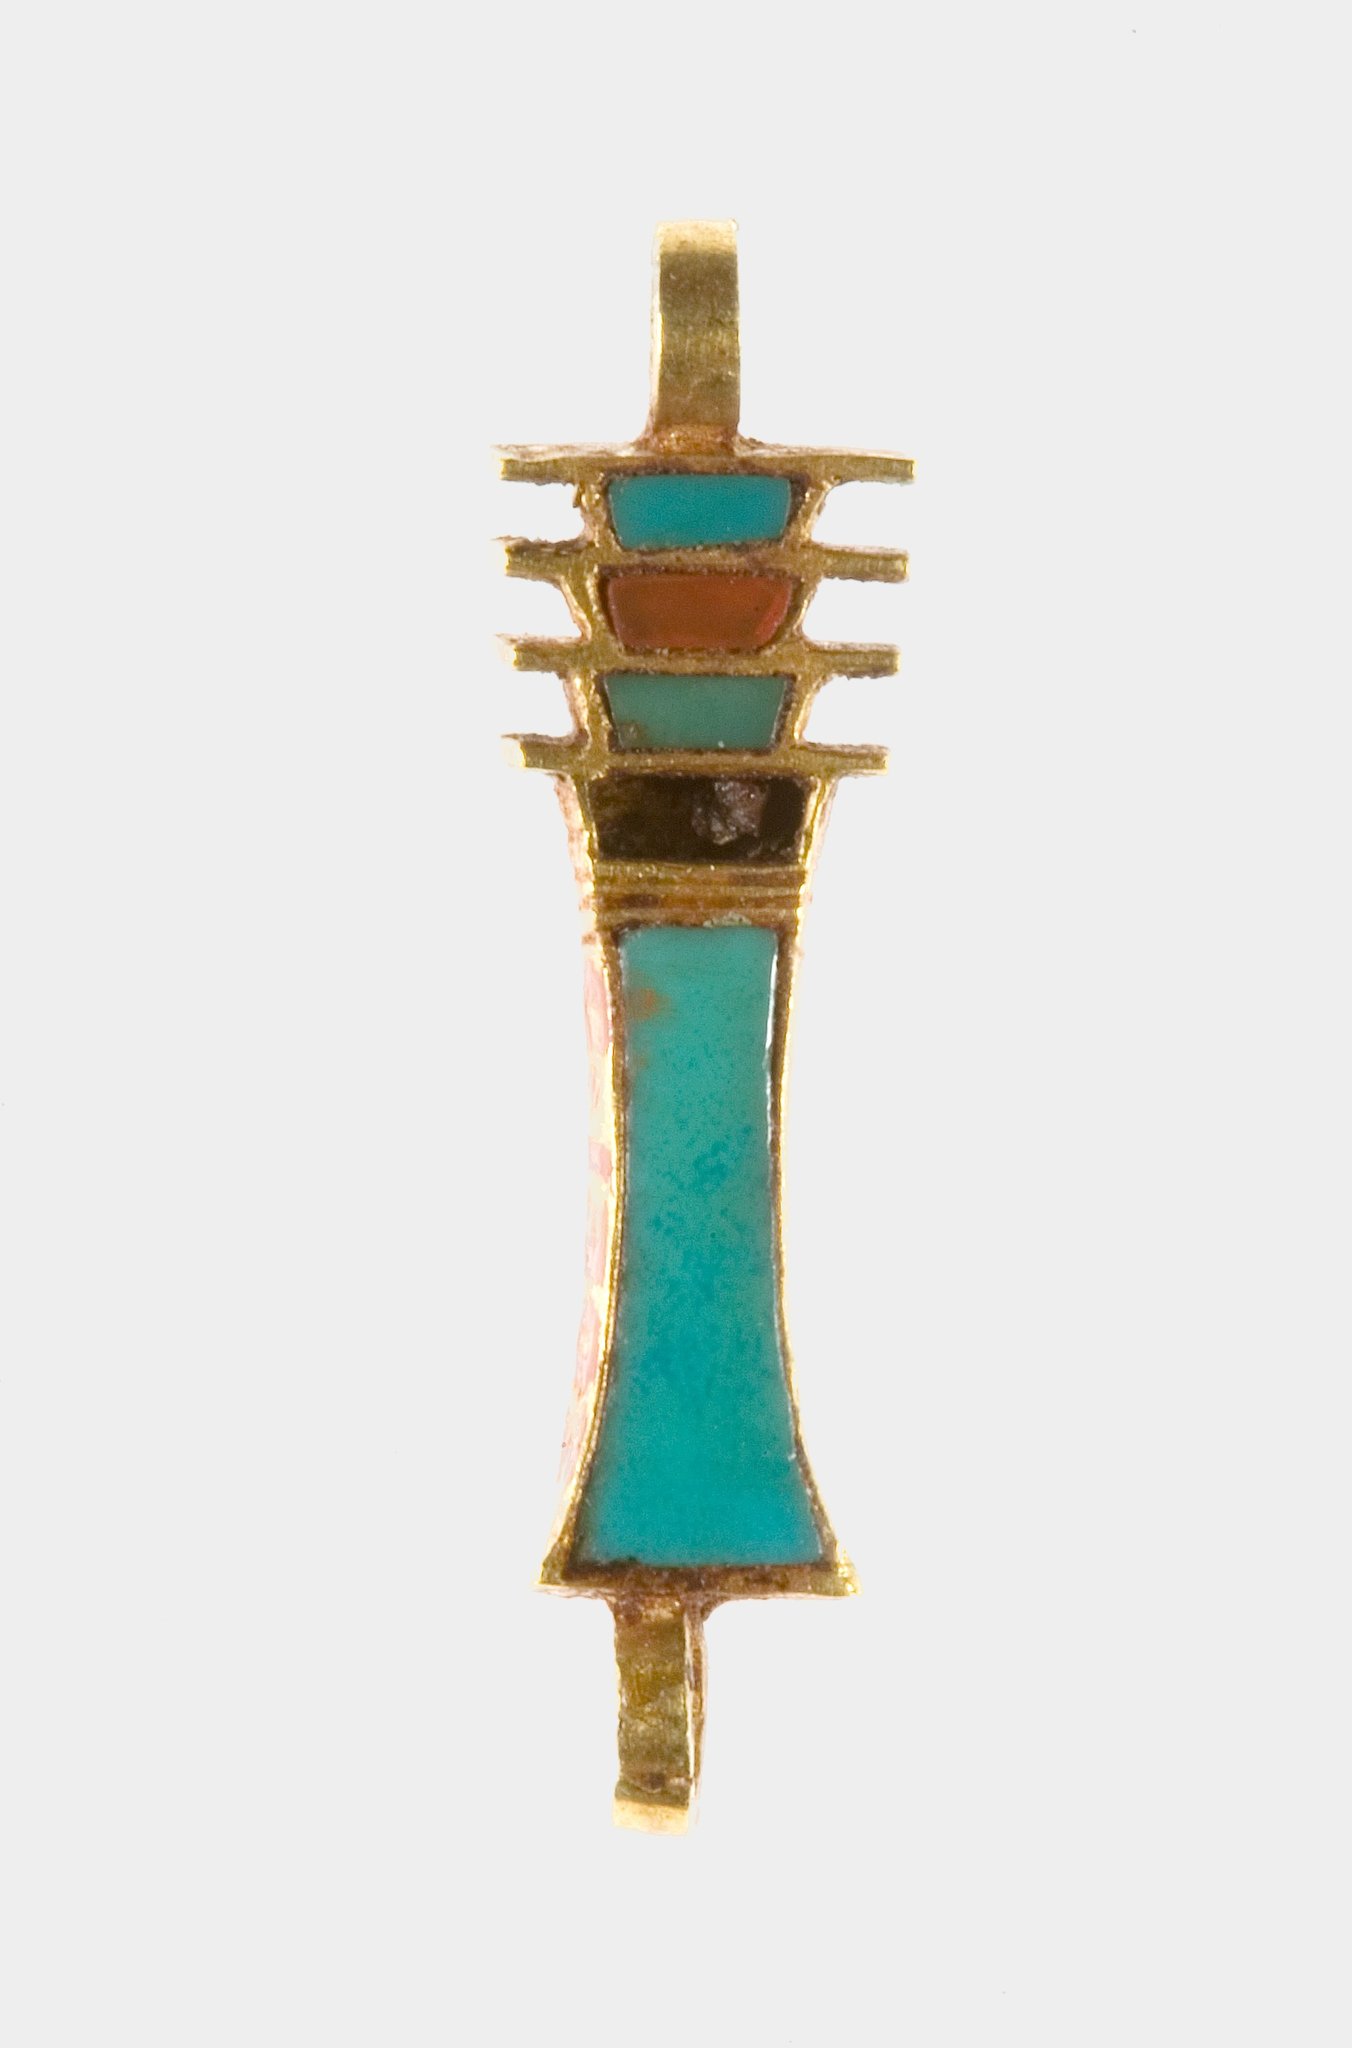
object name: pendant, djed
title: Jewelry element in the form of a djed pillar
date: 1878-1805 BCE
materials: gemstone, gold, lapis lazuli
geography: memphite region